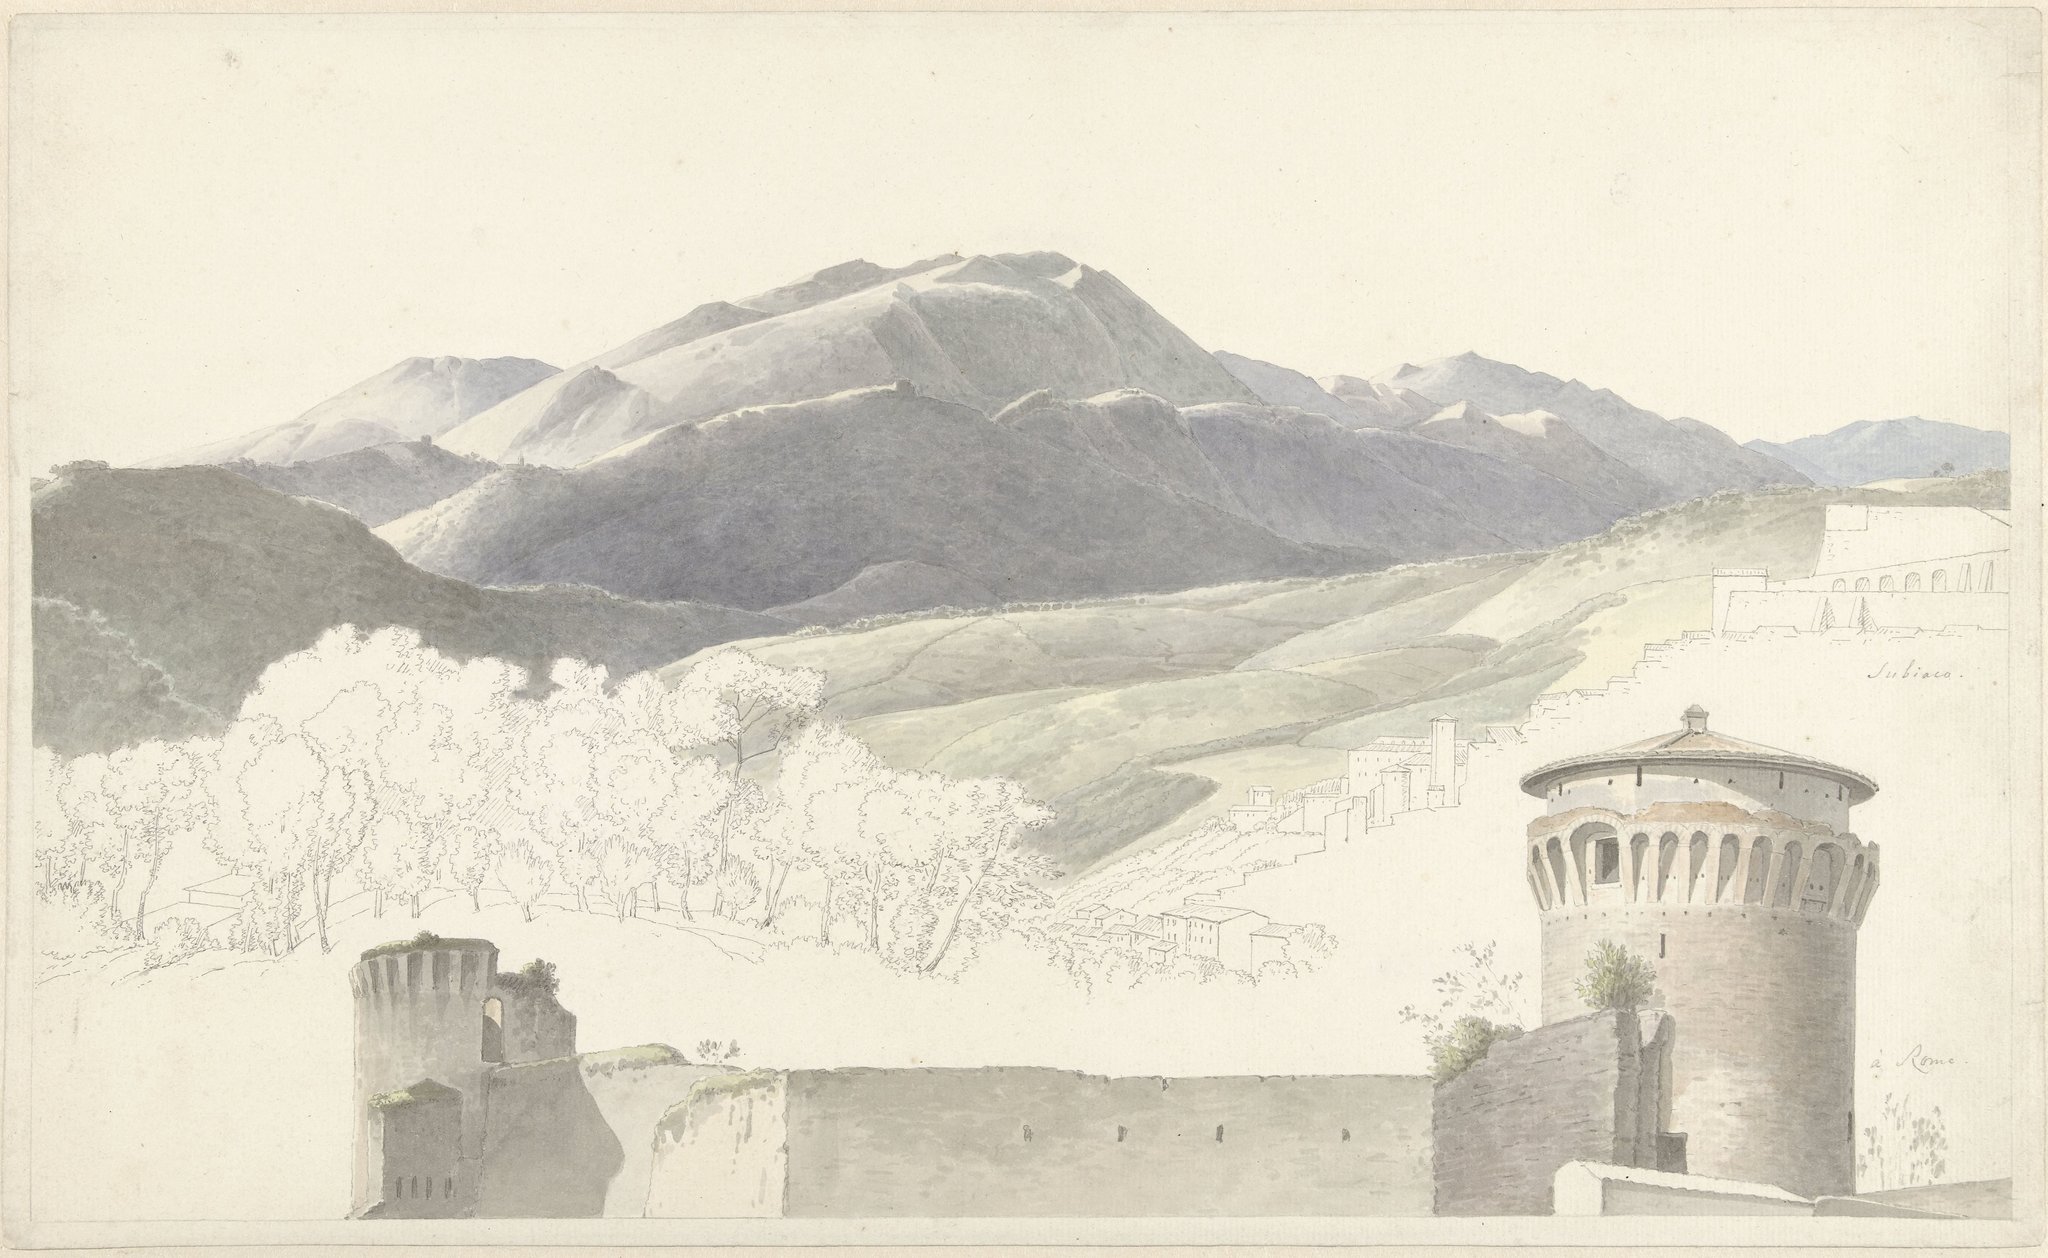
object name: drawing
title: Landschap bij Subiaco en bouwwerk te Rome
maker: josephus augustus knip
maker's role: draughtsman, painter, print maker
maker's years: 1777-1847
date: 1787-1847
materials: ink, paper, pencil, watercolor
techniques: brush, pen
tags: landscapes in the temperate zone, rome